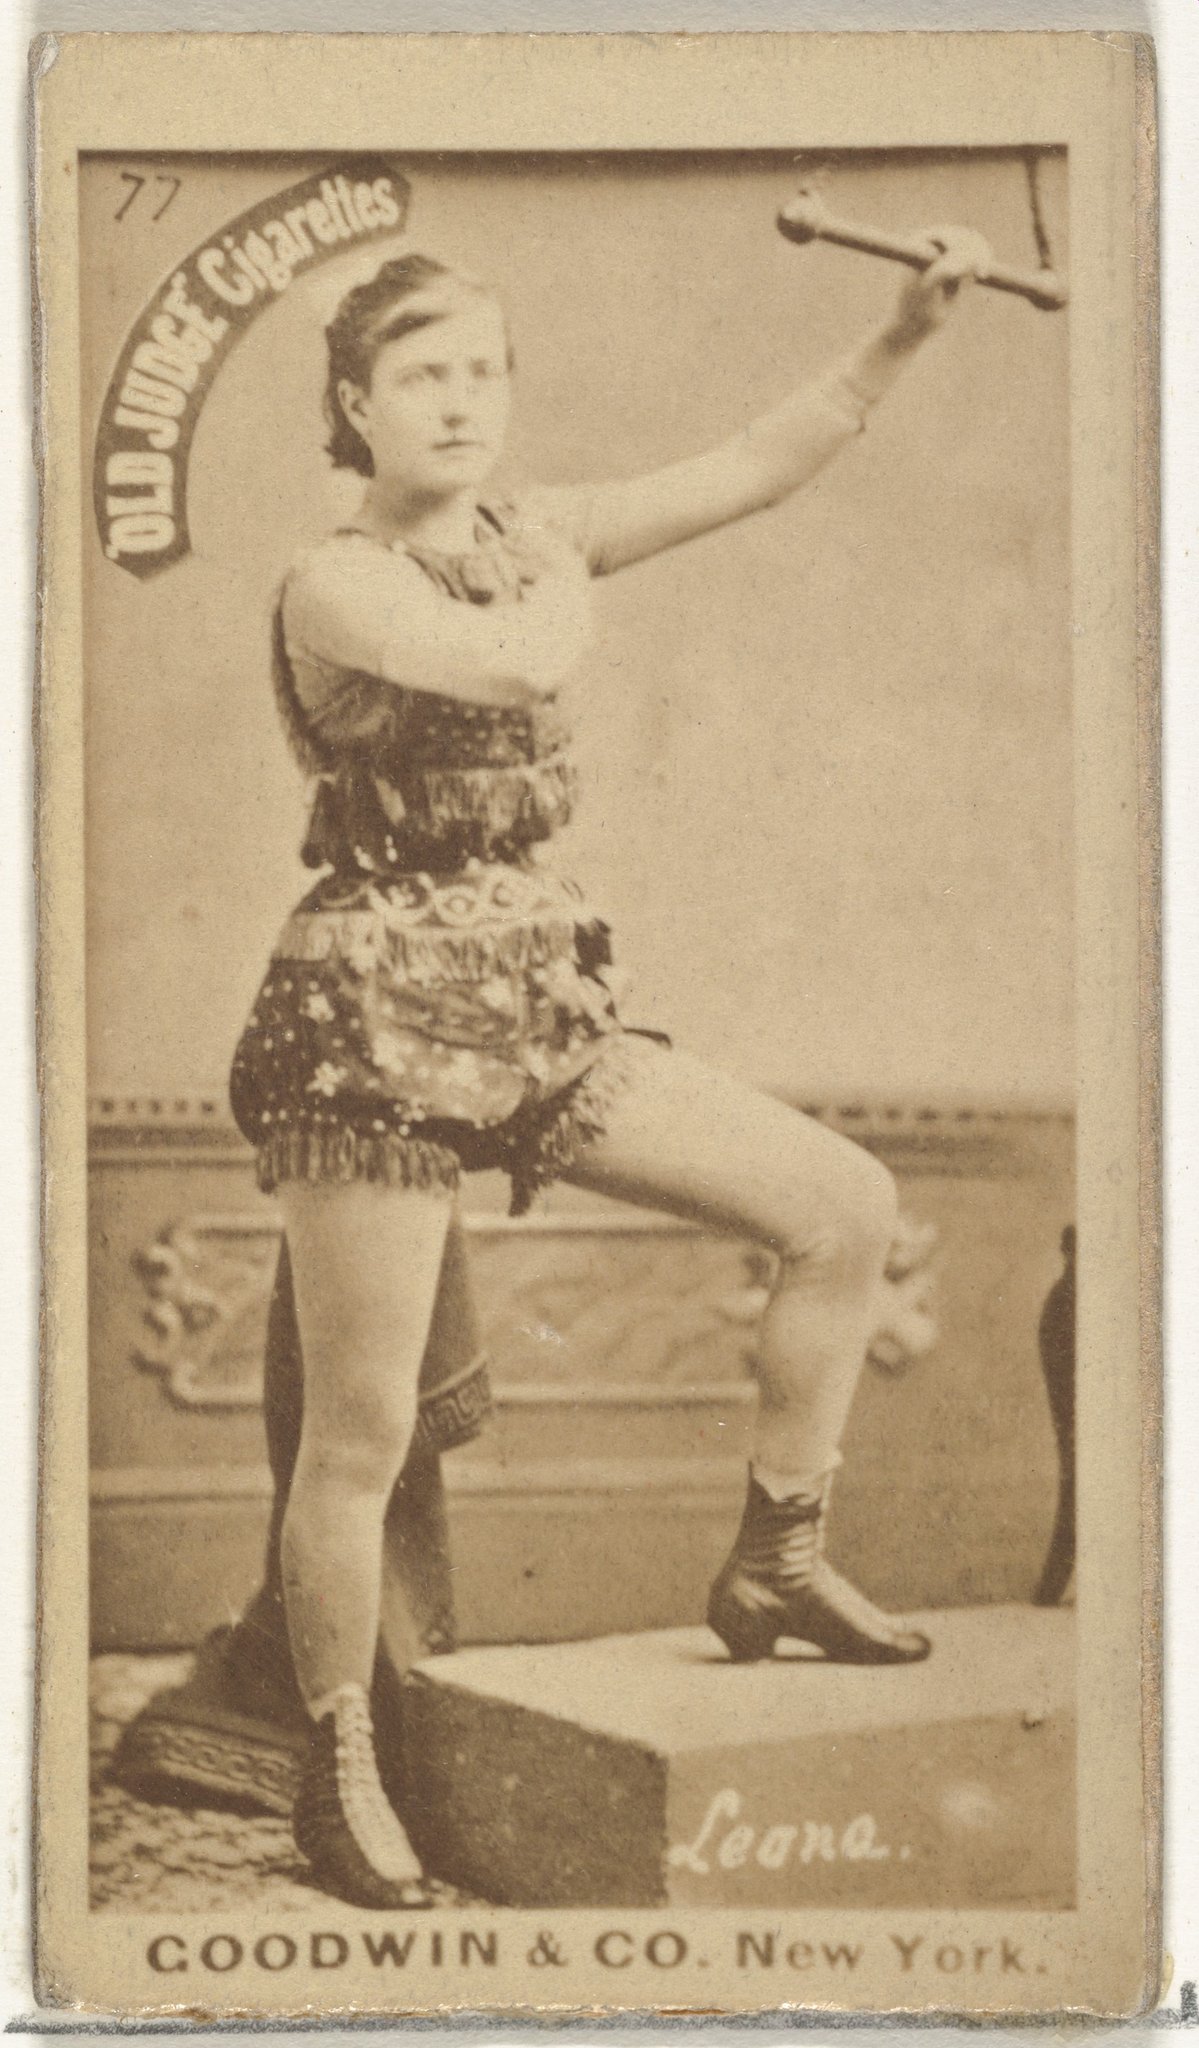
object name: photograph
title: Leona, from the Actors and Actresses series (N171) for Old Judge Cigarettes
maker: goodwin & company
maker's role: publisher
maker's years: 1850-1950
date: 1886-1890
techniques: albumen silver print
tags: portraits,women,actresses